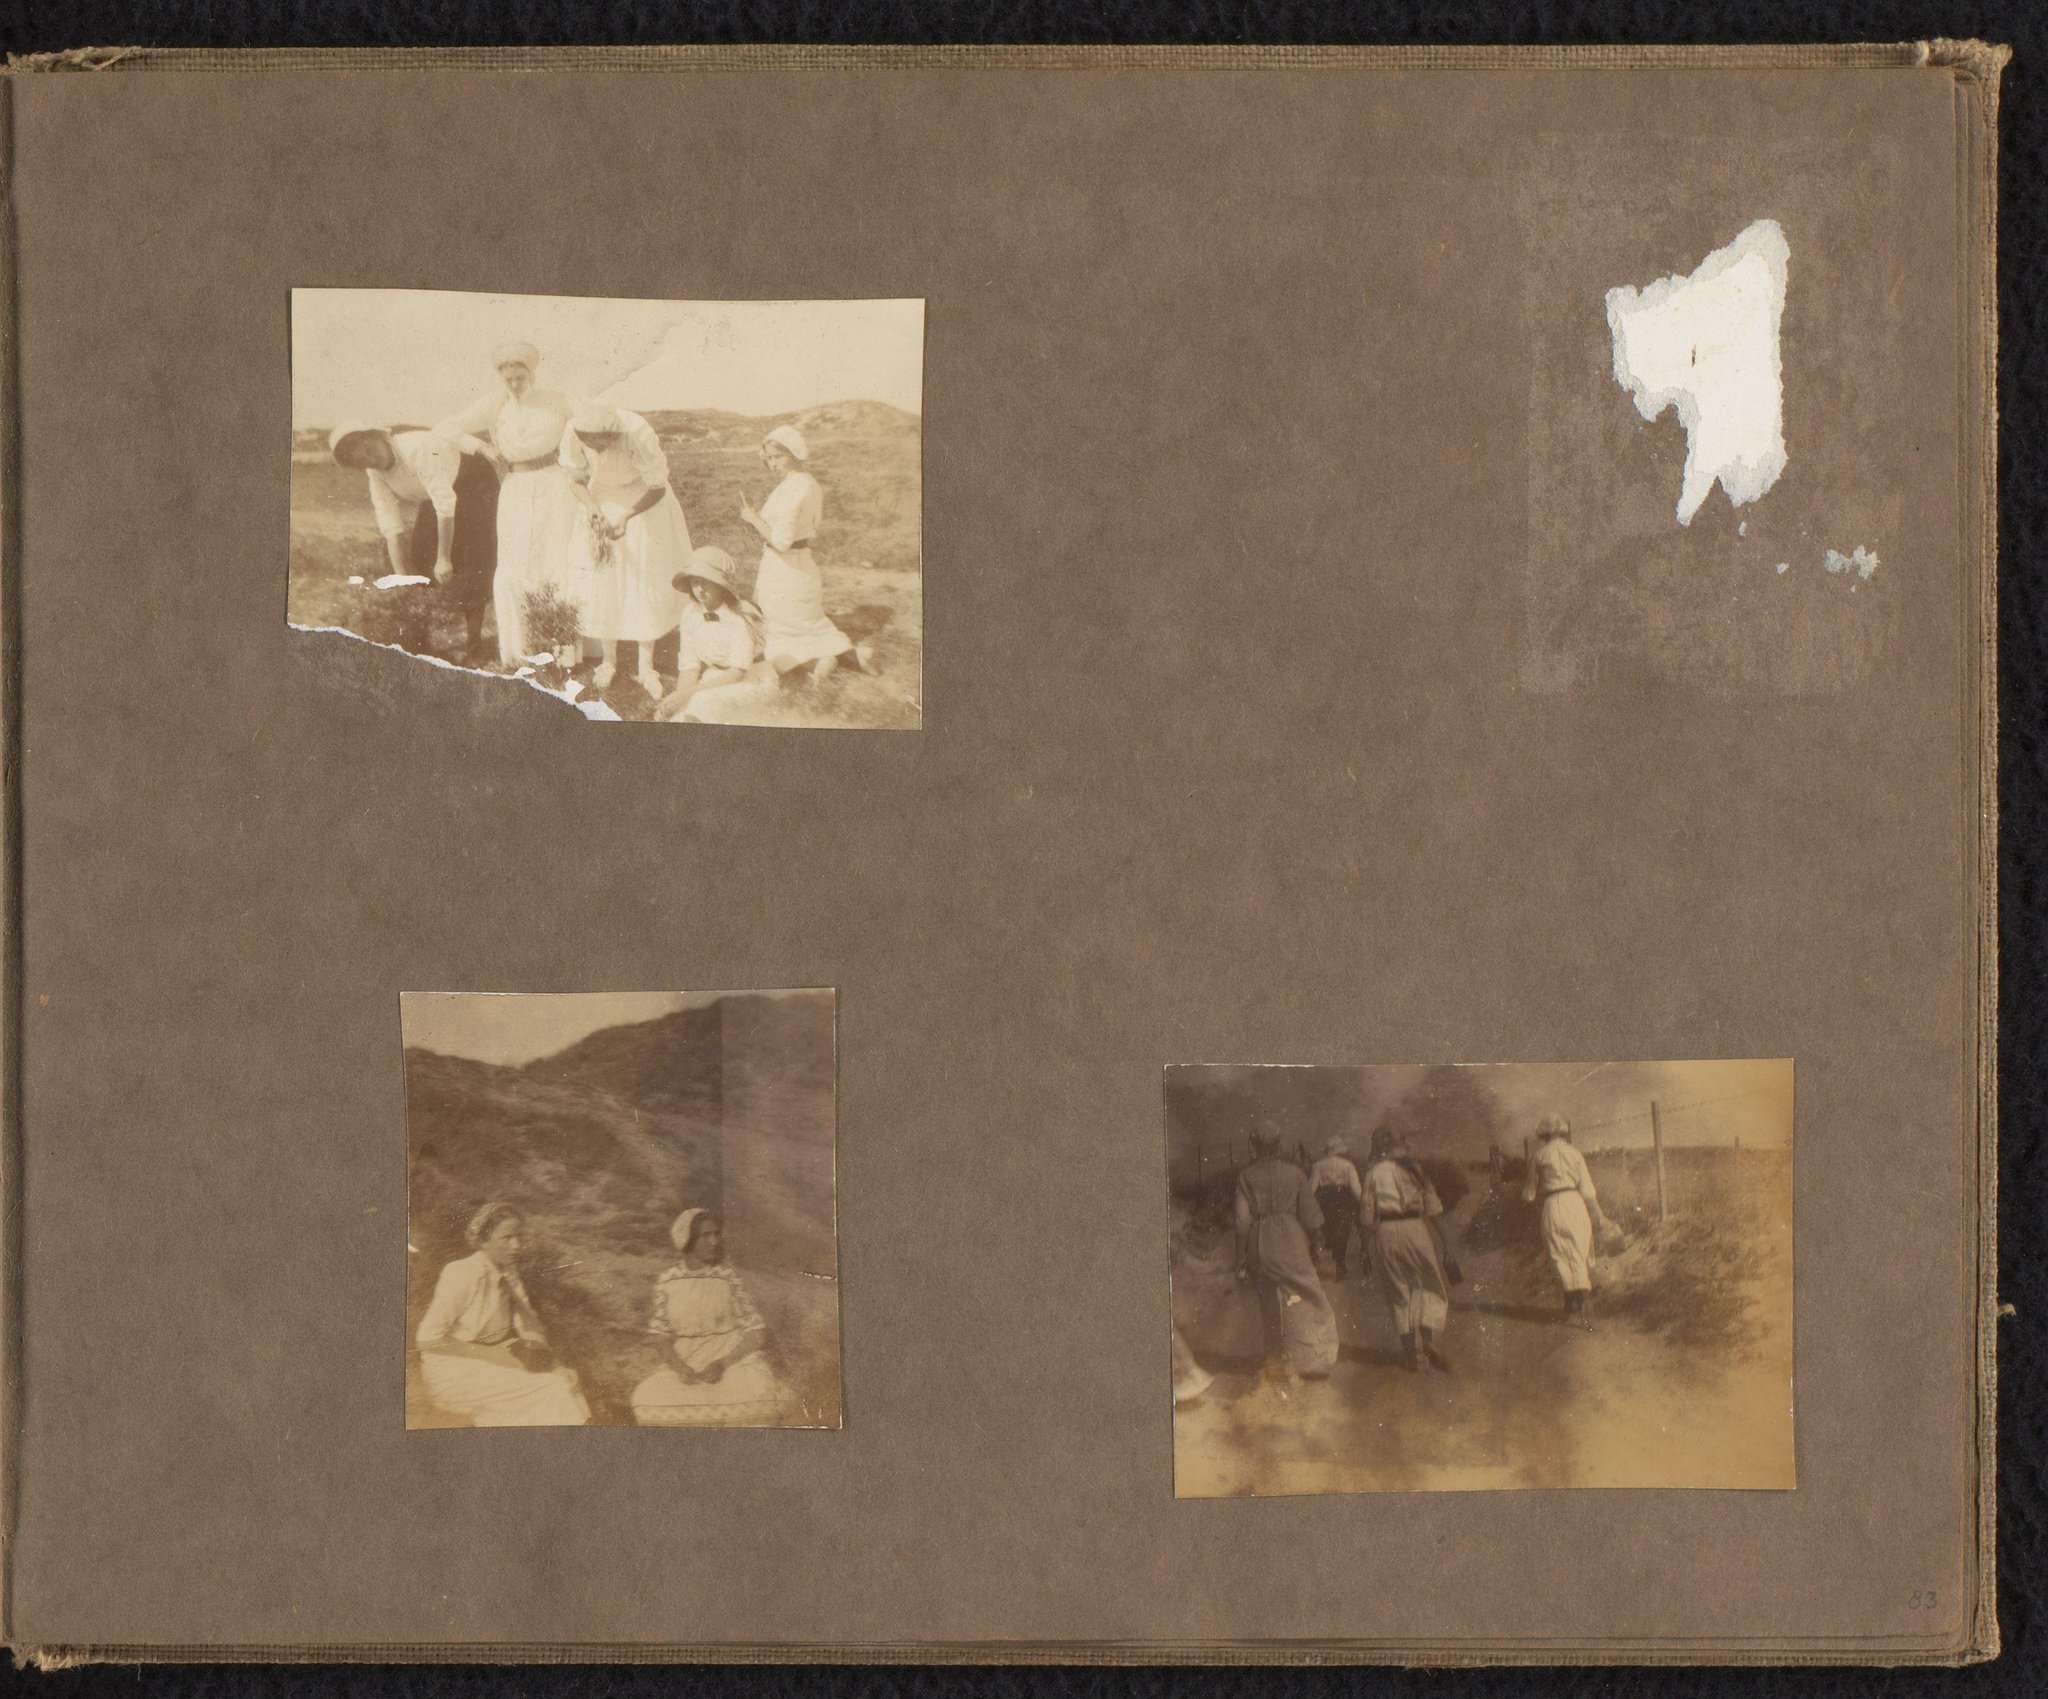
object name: album leaf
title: Drie foto's van mensen in de duinen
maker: carolina frederika onnen (lien/loen)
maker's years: 1896-1983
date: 1908-1911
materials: paper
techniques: gelatin silver print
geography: noordwijk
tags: dunes (sea not visible); in the dunes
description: Deze foto's maken deel uit van een album.